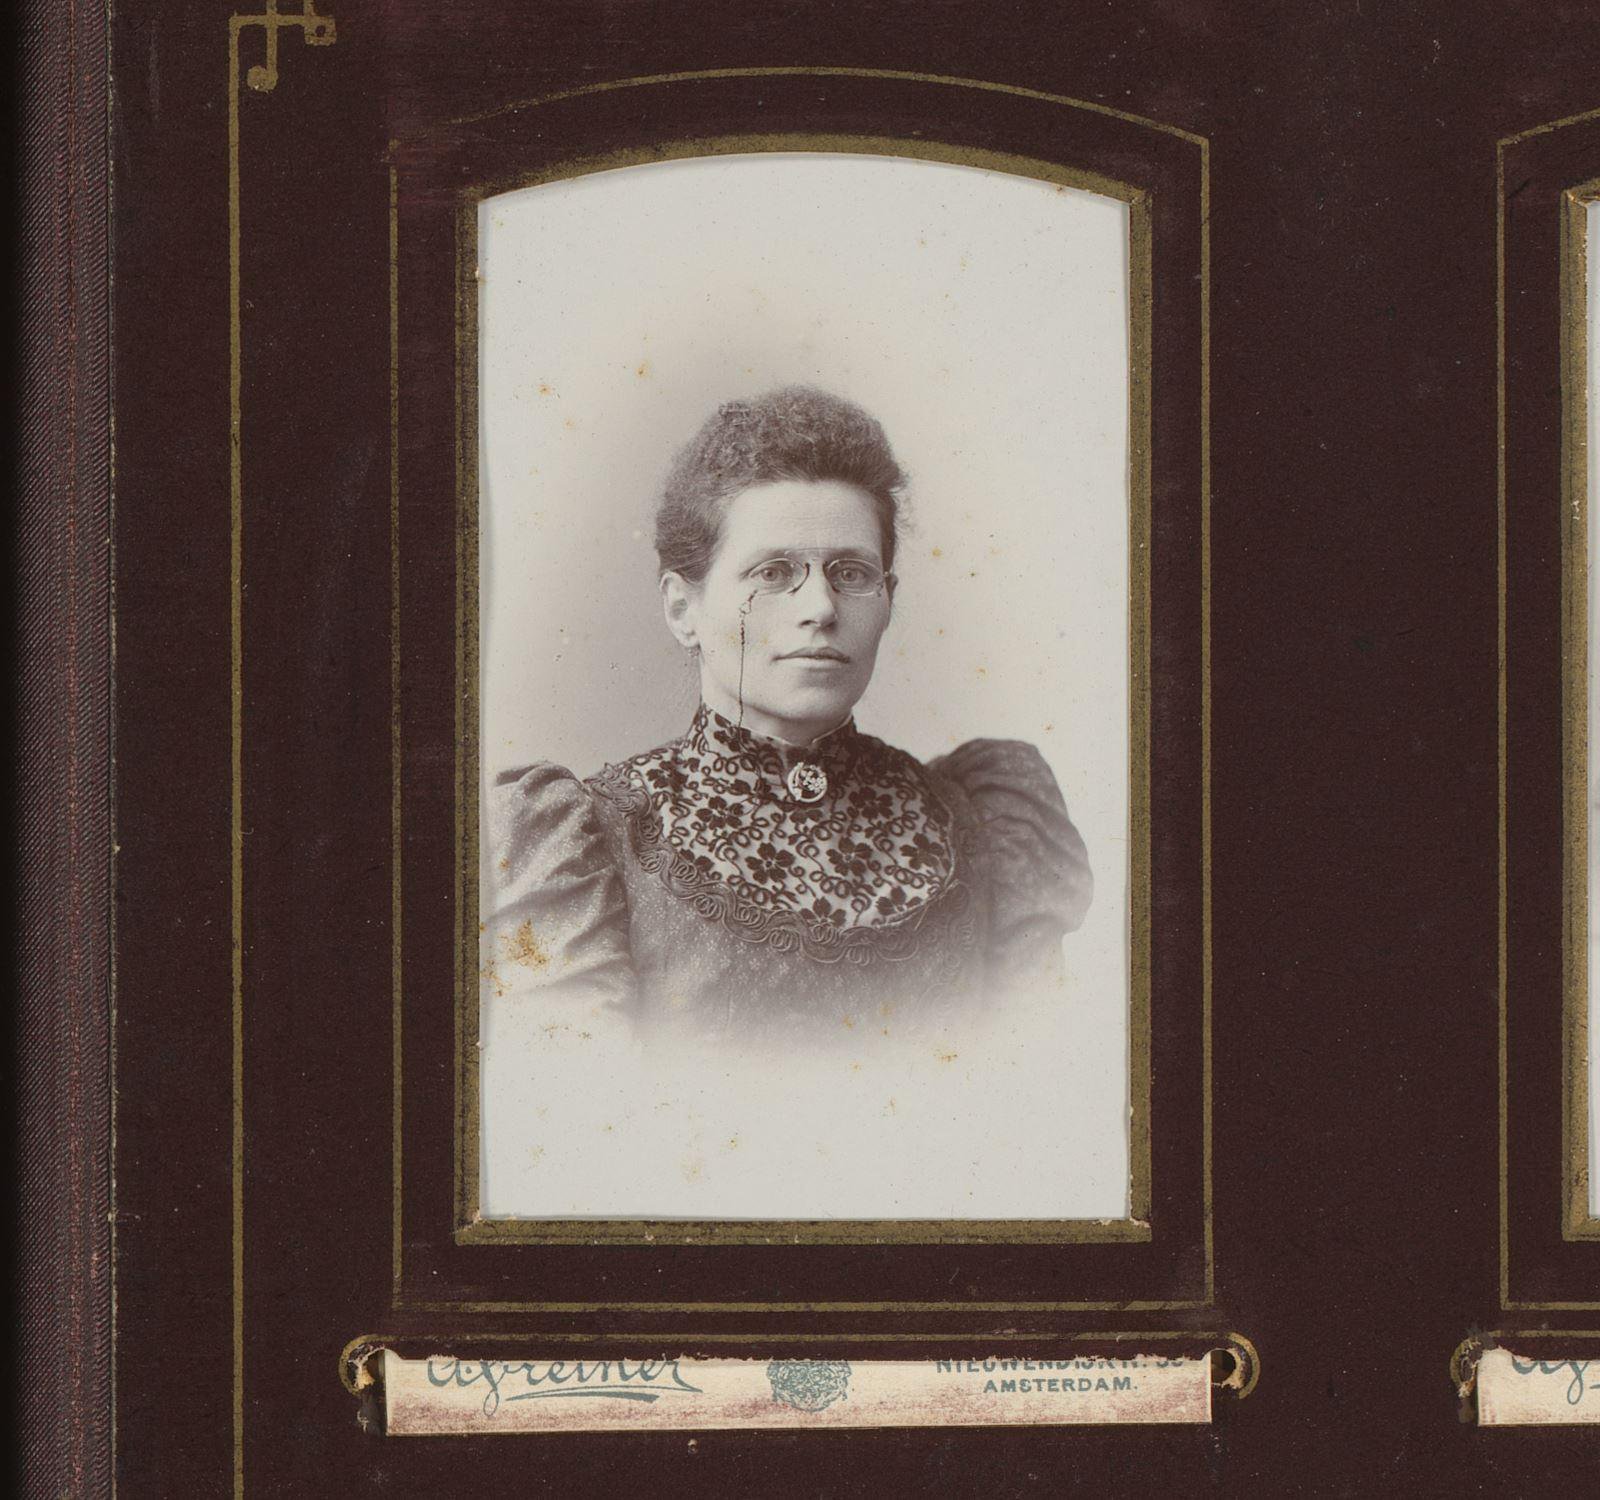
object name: carte de visite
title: Portret van een vrouw met lorgnet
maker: albert greiner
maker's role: fotograaf, fotostudio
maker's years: 1833-1890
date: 1883-1887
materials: cardboard, photographic support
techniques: collodion silver print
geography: amsterdam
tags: eyeglasses, spectacles, historical persons - bb - woman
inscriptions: inscription: ‘Anno./ No 9806av./ De plaat blijft bewaard, gelieve bij/ bestelling dit Nummer op te geven./ Albert Greiner/ Photograaf van wijlen Z.M. den Koning Willem III/ en van H.M. de Koningin Weduwe./ BEKROOND/ te/ Paris 1878/ Amsterdam 1877/ Arnhem 1879/ Amsterdam 1883/ Amsterdam/ Nieuwendijk No 89./ SPECIALITEIT IN VERGROOTINGEN.’